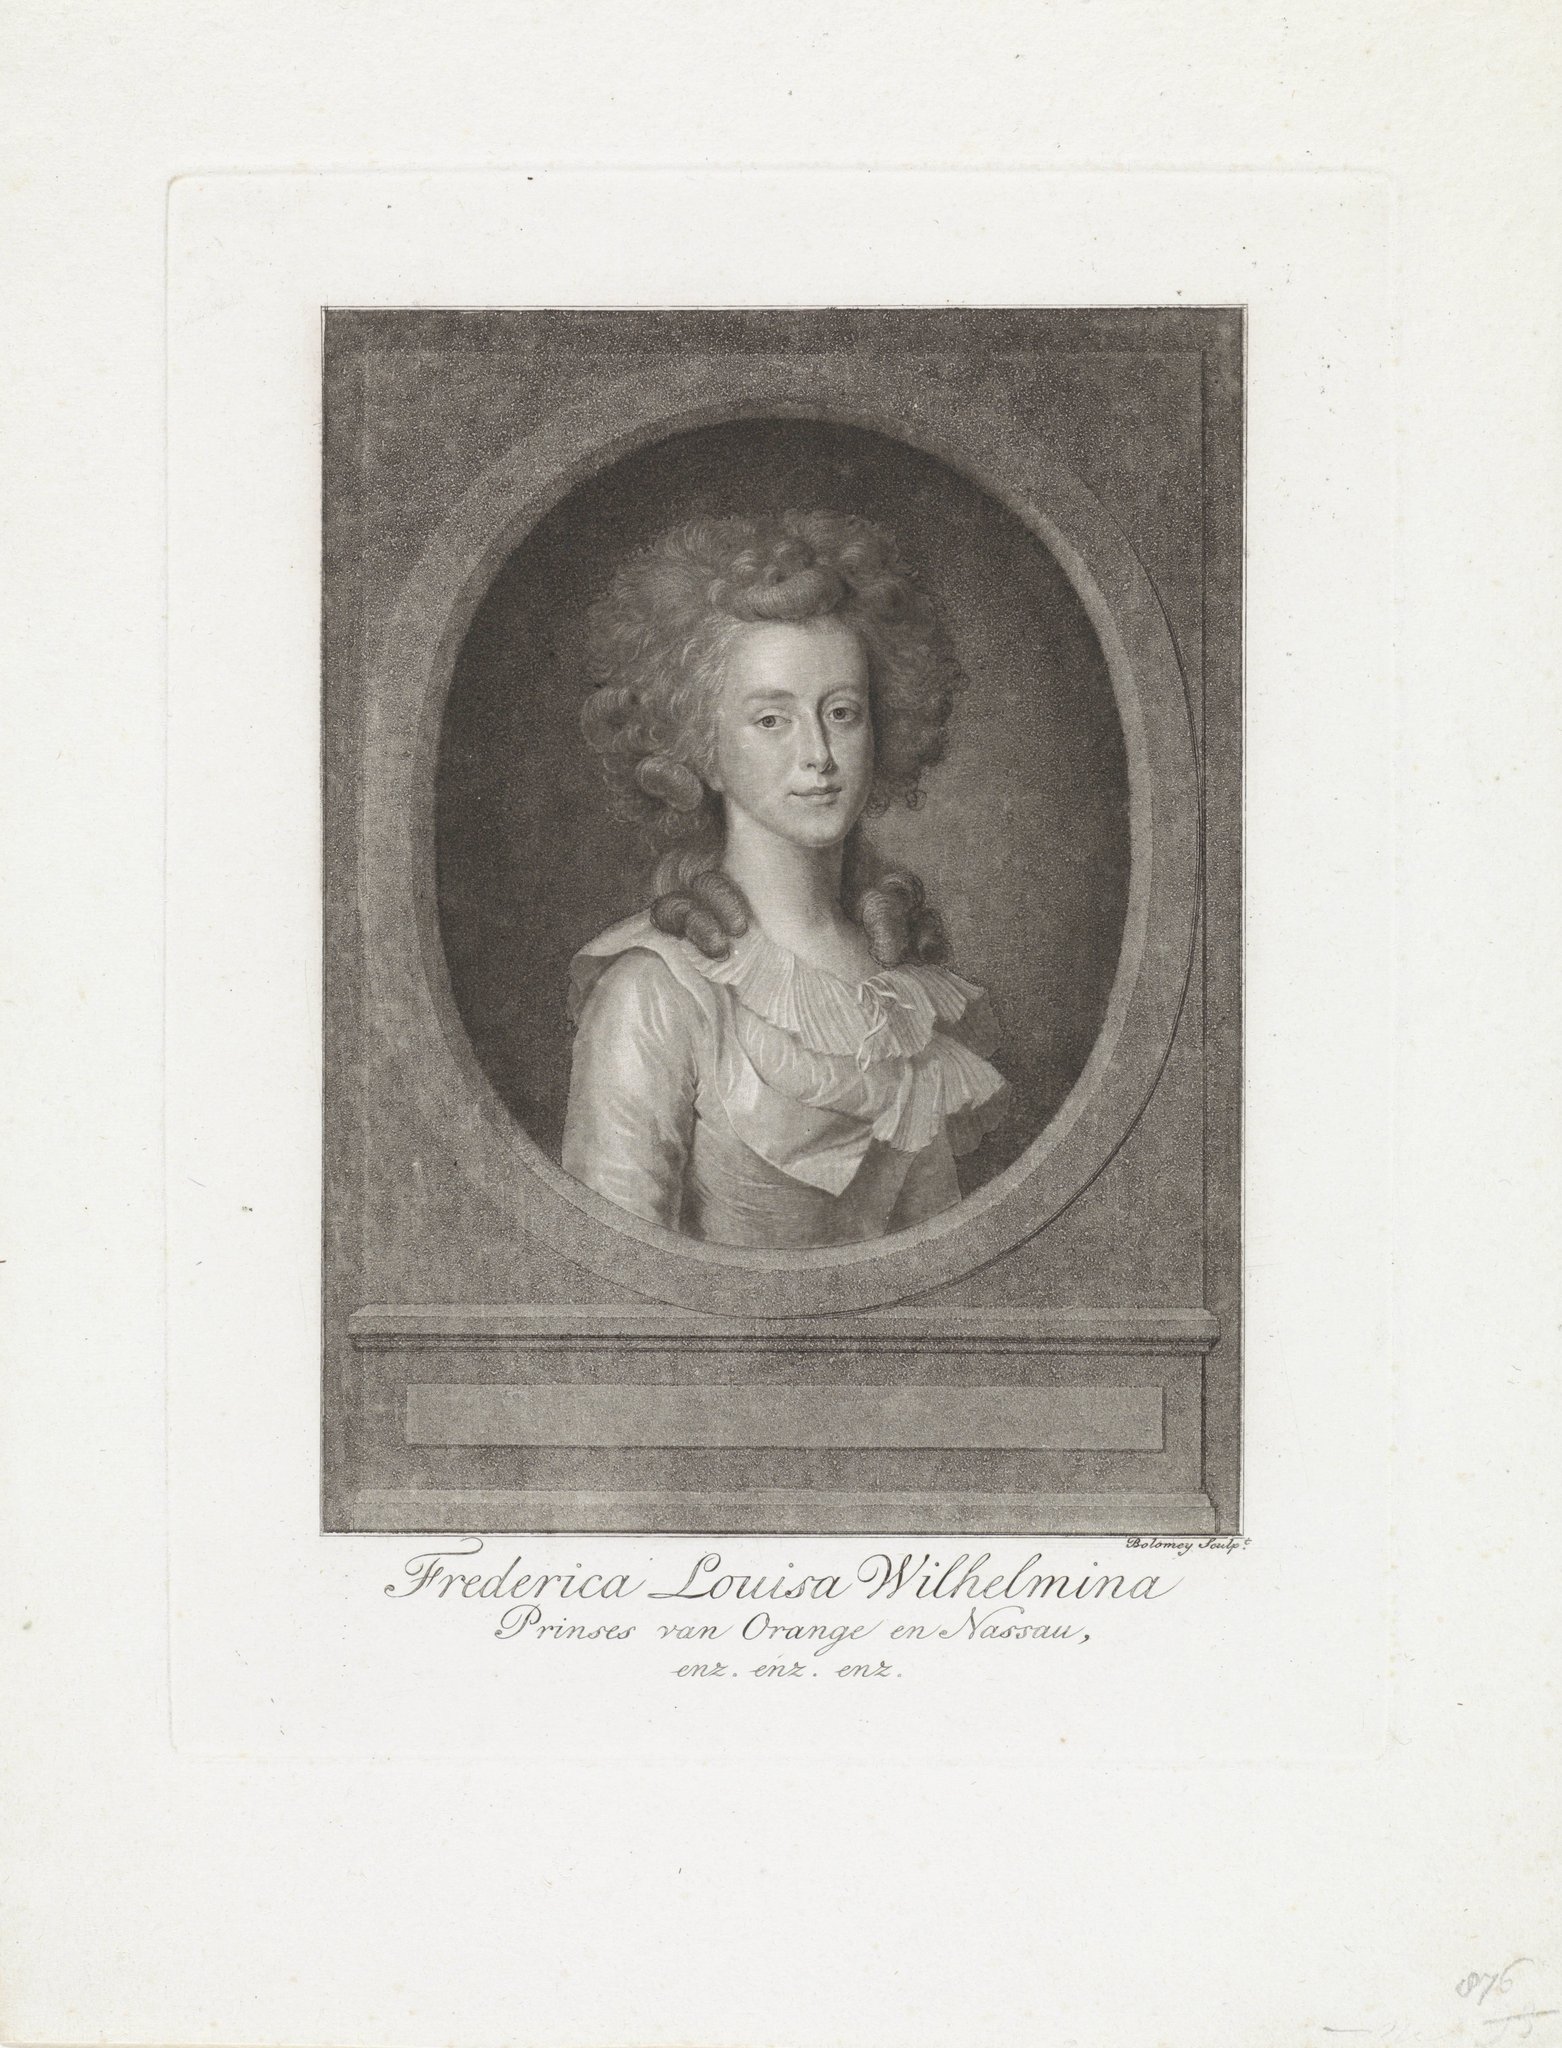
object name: print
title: Portret van Frederica Louisa Wilhelmina, prinses van Oranje-Nassau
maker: benjamin samuel bolomey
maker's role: print maker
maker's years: 1739-1819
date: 1788-1791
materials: paper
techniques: aquatint, etching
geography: the hague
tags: amsterdam, louise (prinses van oranje-nassau)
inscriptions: collector's mark: Lugt 963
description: Portret van Frederica Louisa Wilhelmina, prinses van Oranje-Nassau. Echtgenote van Karel George August, kroonprins van Brunswijk-Wolfenbüttel.